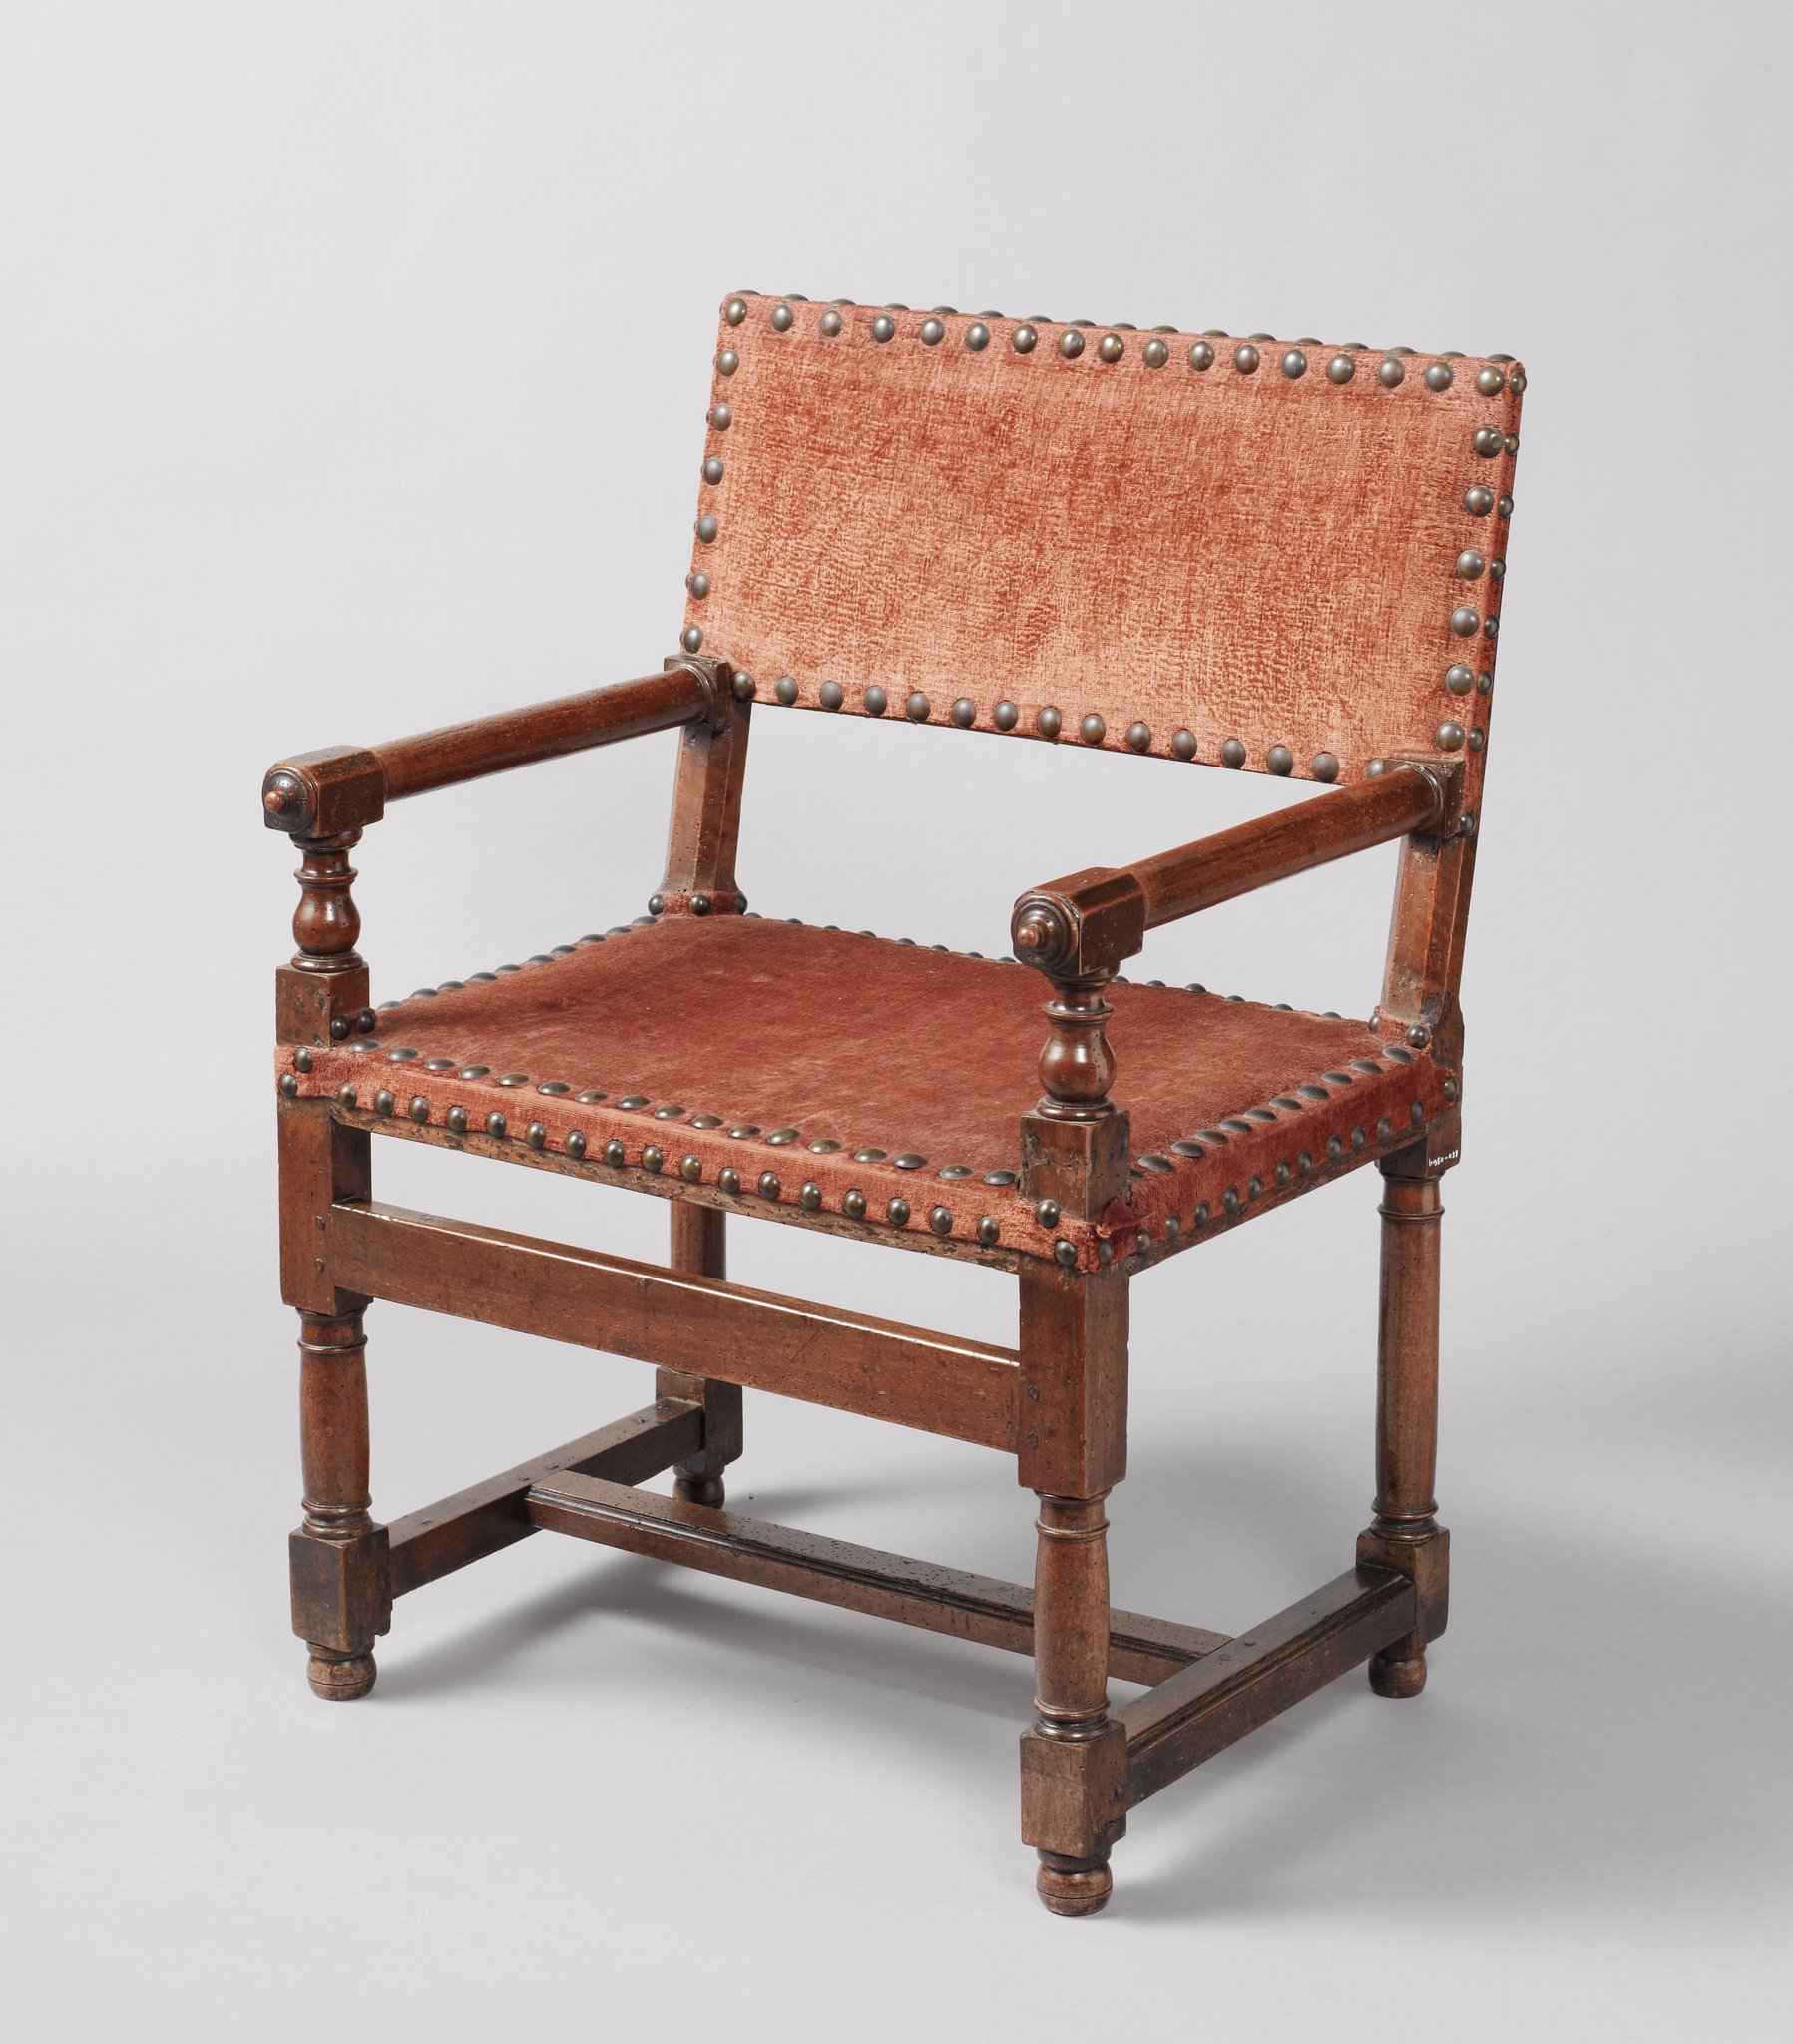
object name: armchair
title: Armchair from the prison cell of Johan van Oldenbarnevelt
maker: Anonymous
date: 1600-1650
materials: textile, wood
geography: northern netherlands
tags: the hague, johan van oldenbarnevelt, prison, jail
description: In 1618 Grand Pensionary Johan van Oldenbarnevelt was imprisoned and tried in The Hague, where he was eventually condemned to death for treason. His political supporters regarded him as a martyr to their cause. According to tradition, he sat on this chair during his final days in prison.